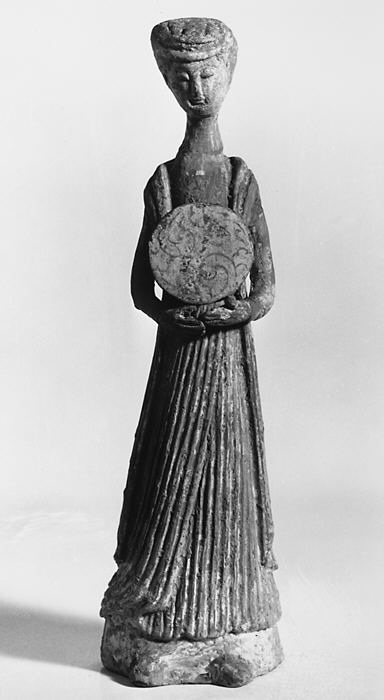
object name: figure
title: Female musician with a drum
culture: chinese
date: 501-600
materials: earthenware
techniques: polychrome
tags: women